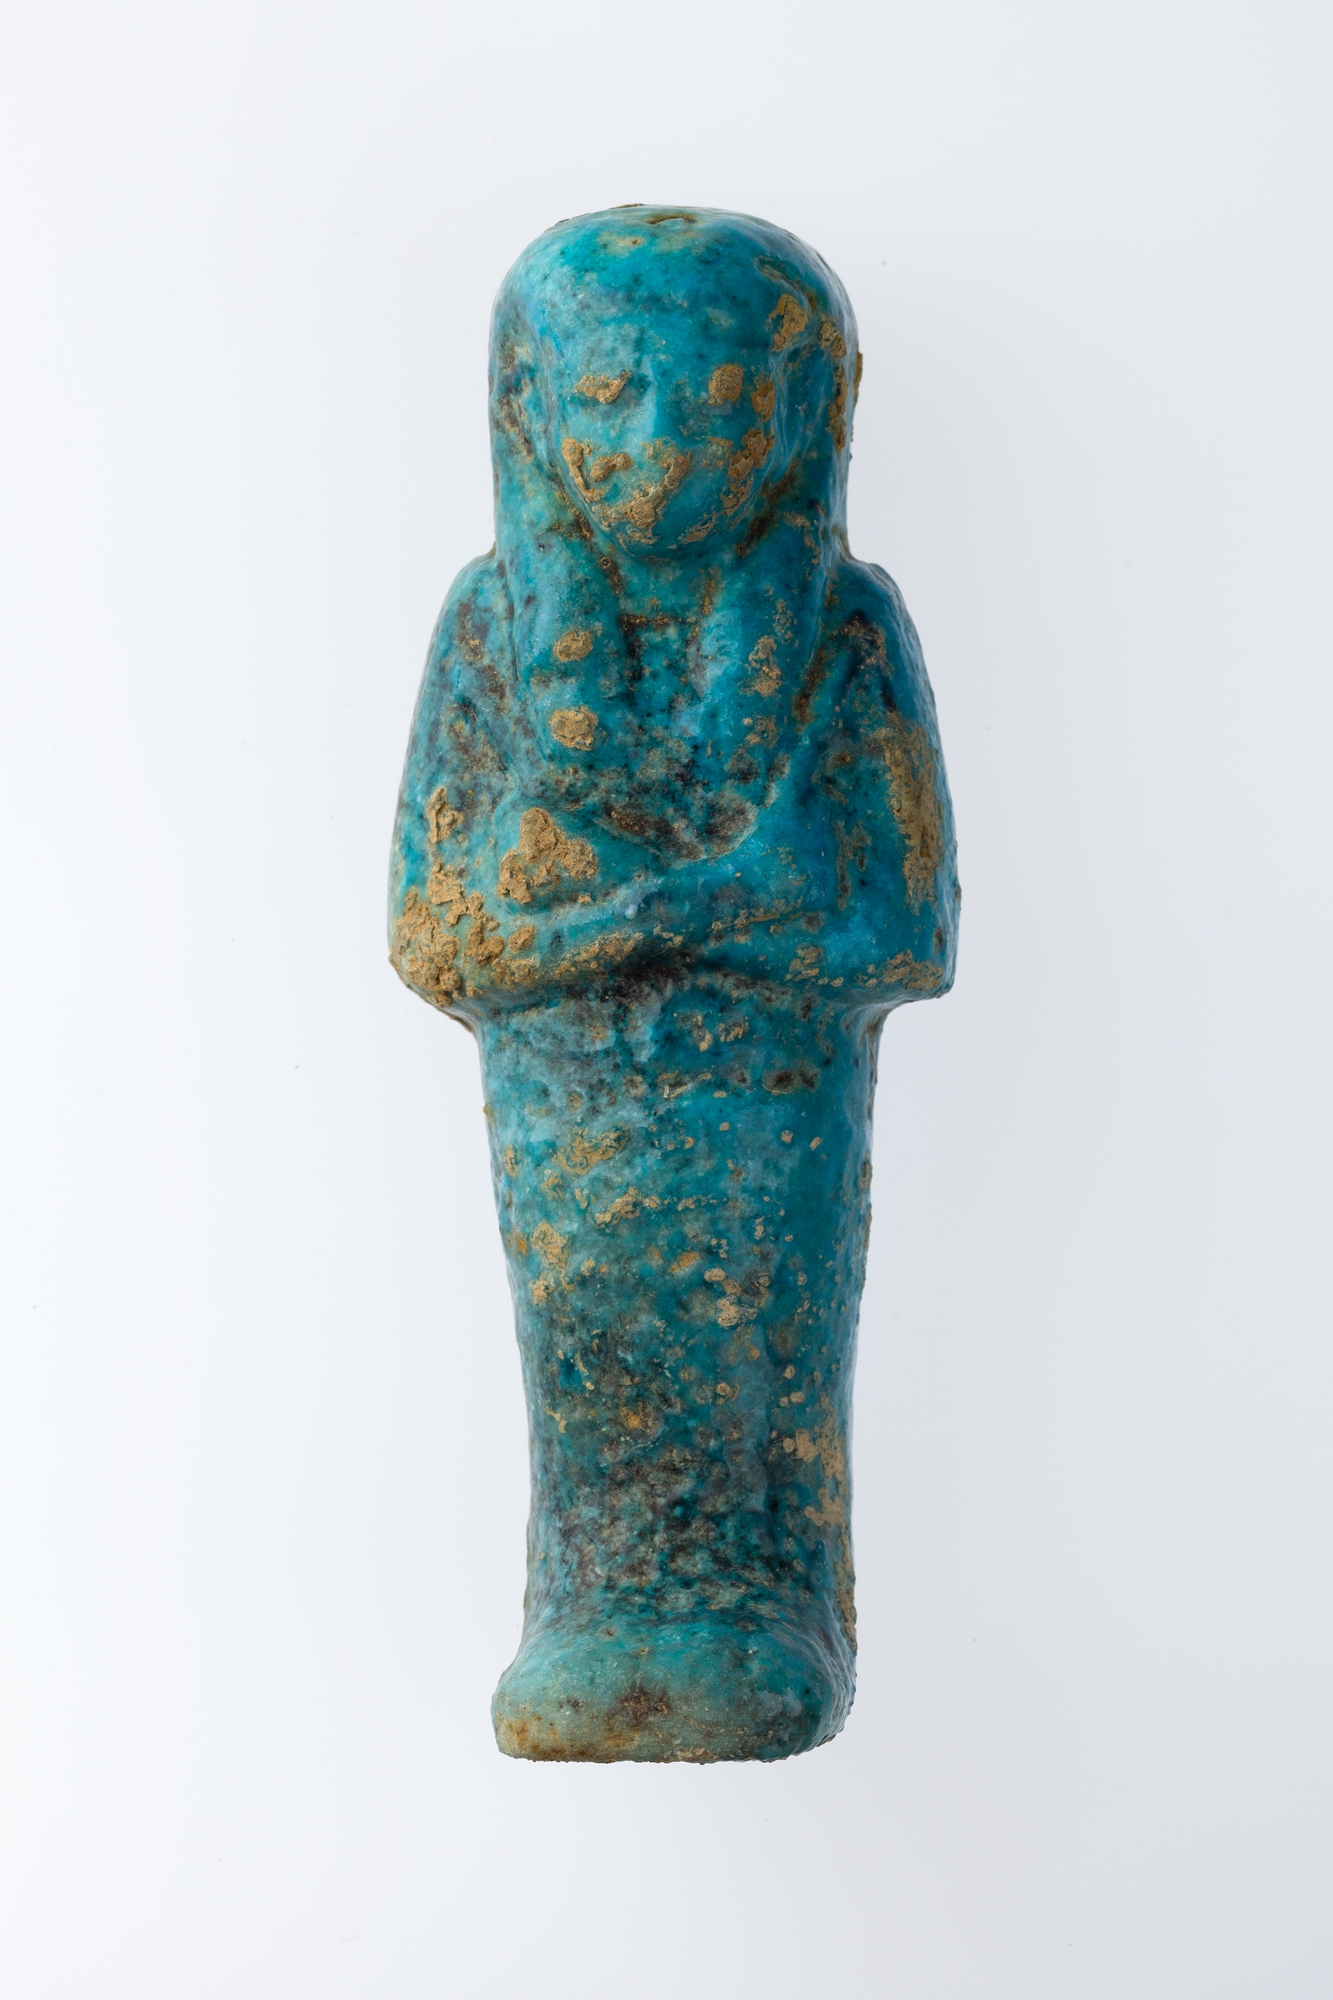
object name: shabti, henettawy c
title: Worker Shabti of Henettawy (C), Daughter of Isetemkheb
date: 990-970 BCE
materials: faience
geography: egypt